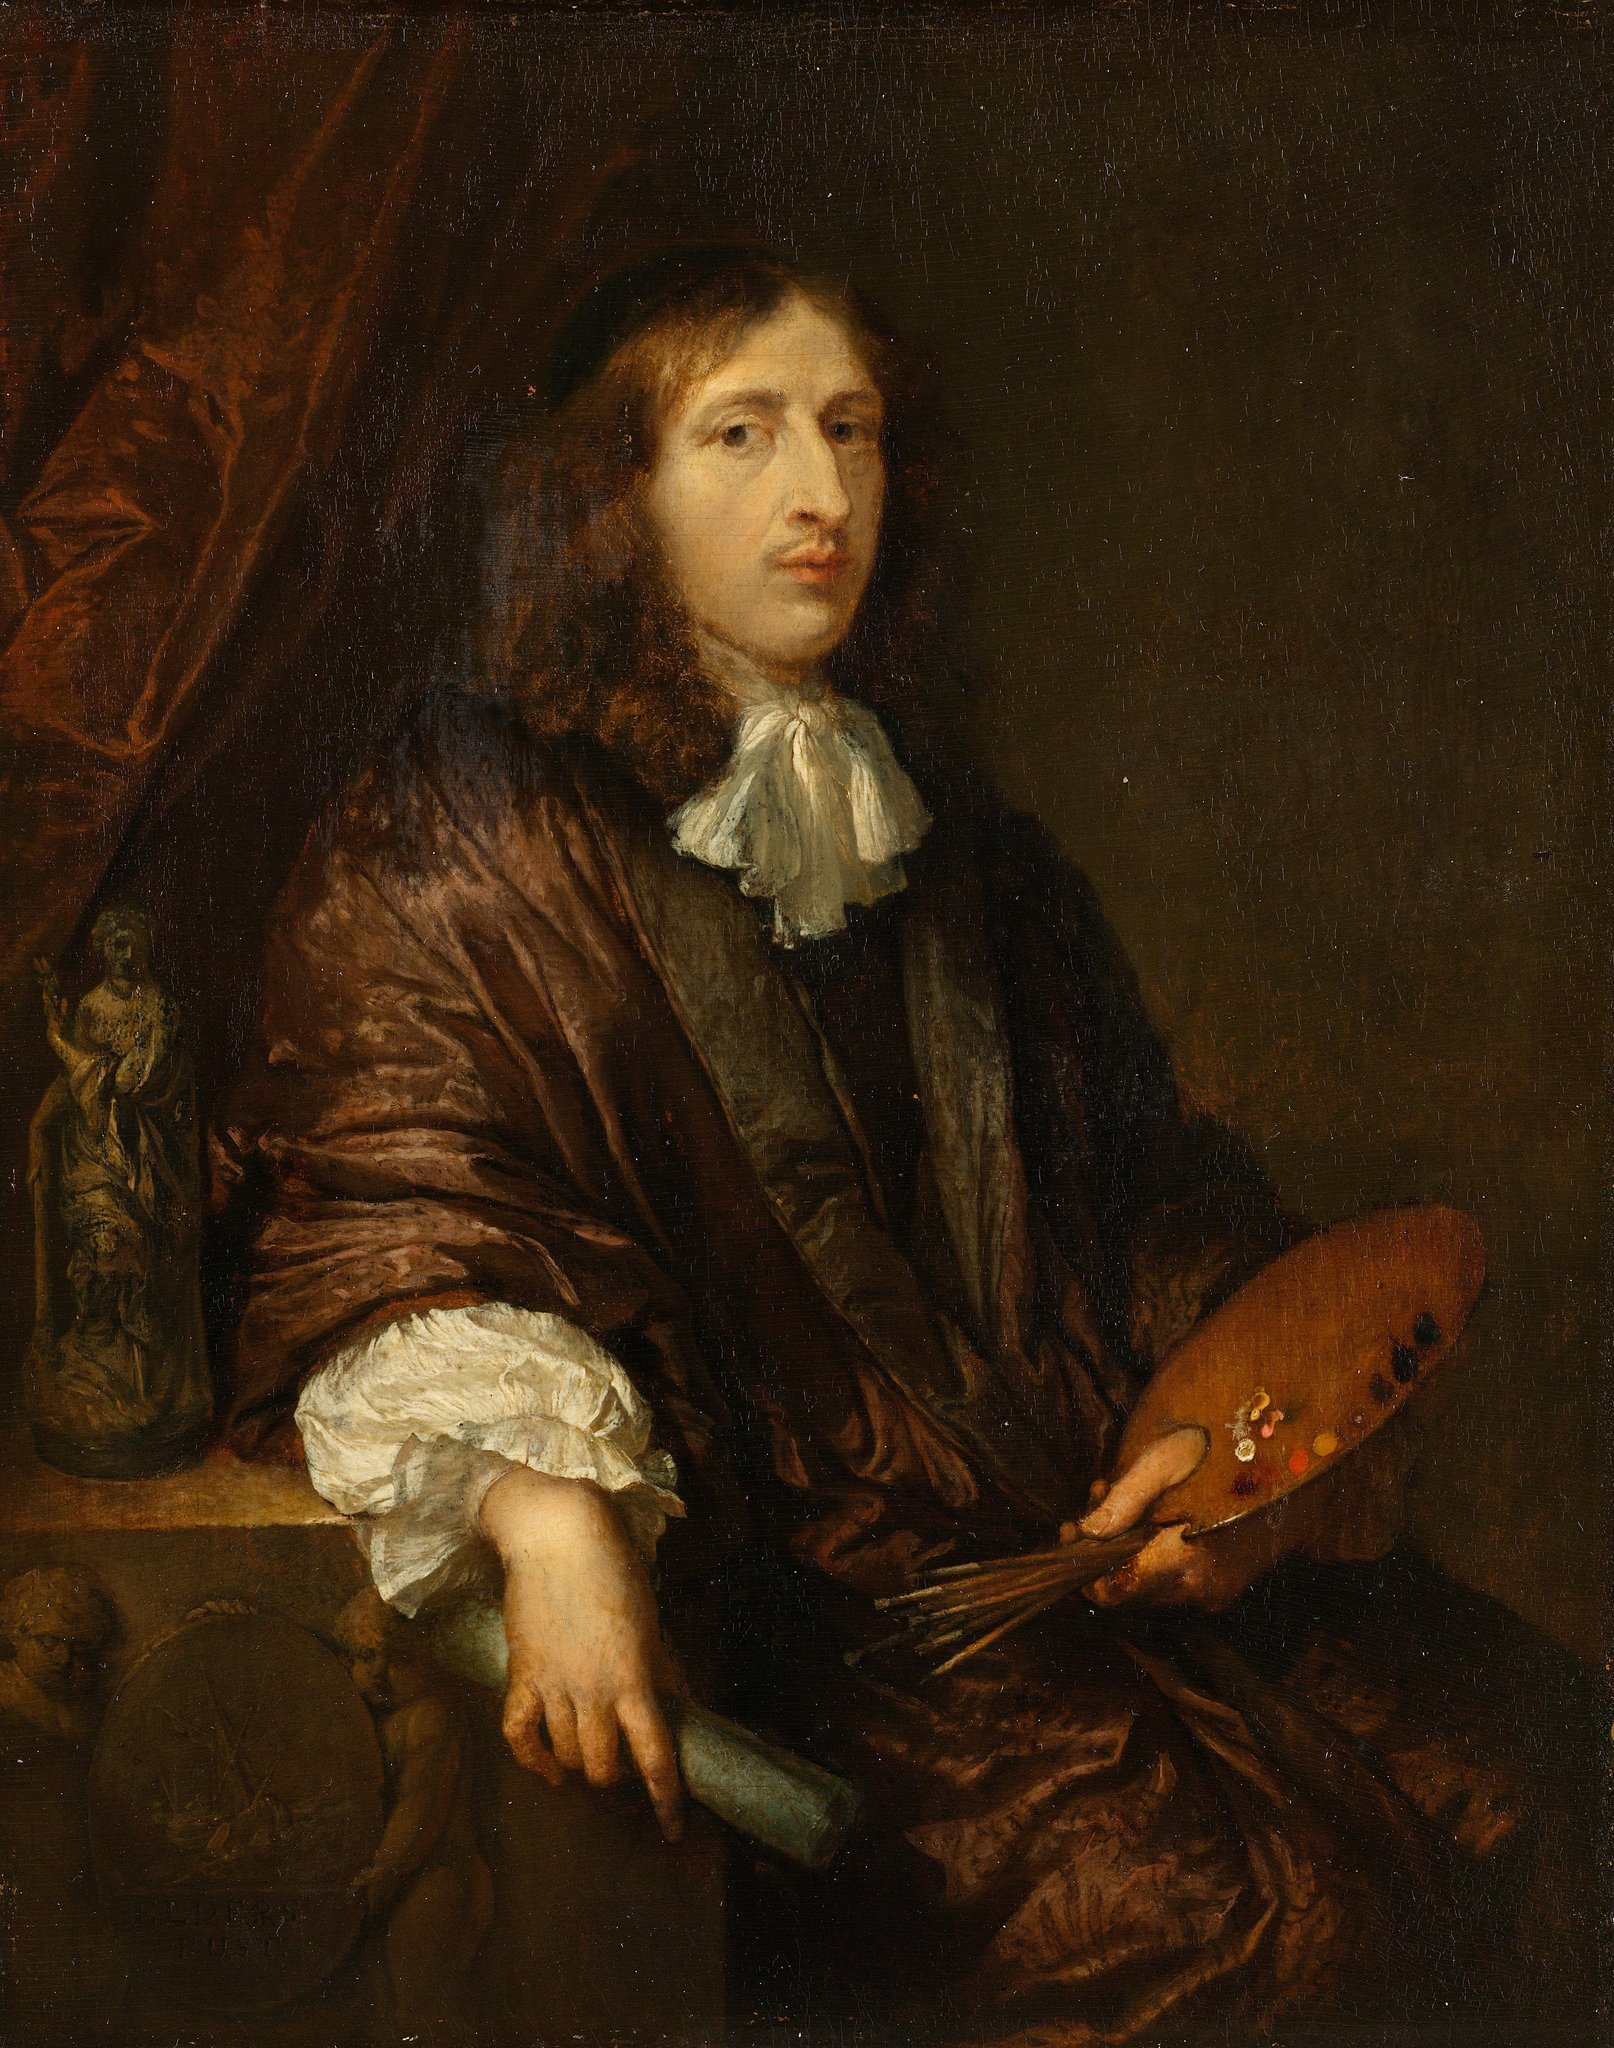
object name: painting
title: Self-Portrait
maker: caspar netscher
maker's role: draughtsman, painter, print maker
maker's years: 1639-1684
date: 1660-1684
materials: oil, panel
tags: the hague, painter, print maker, draughtsman, caspar netscher, historical persons, portrait, self-portrait of painter, portrait, self-portrait of artist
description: Zelfportret van de schilder Caspar Netscher. Kniestuk, zittend, een rol papier in de rechterhand, palet en penselen in de linker. Links een voetstuk met een reliëf van twee putti met een schild met een schuit, op de piedestal staat een beeldje.